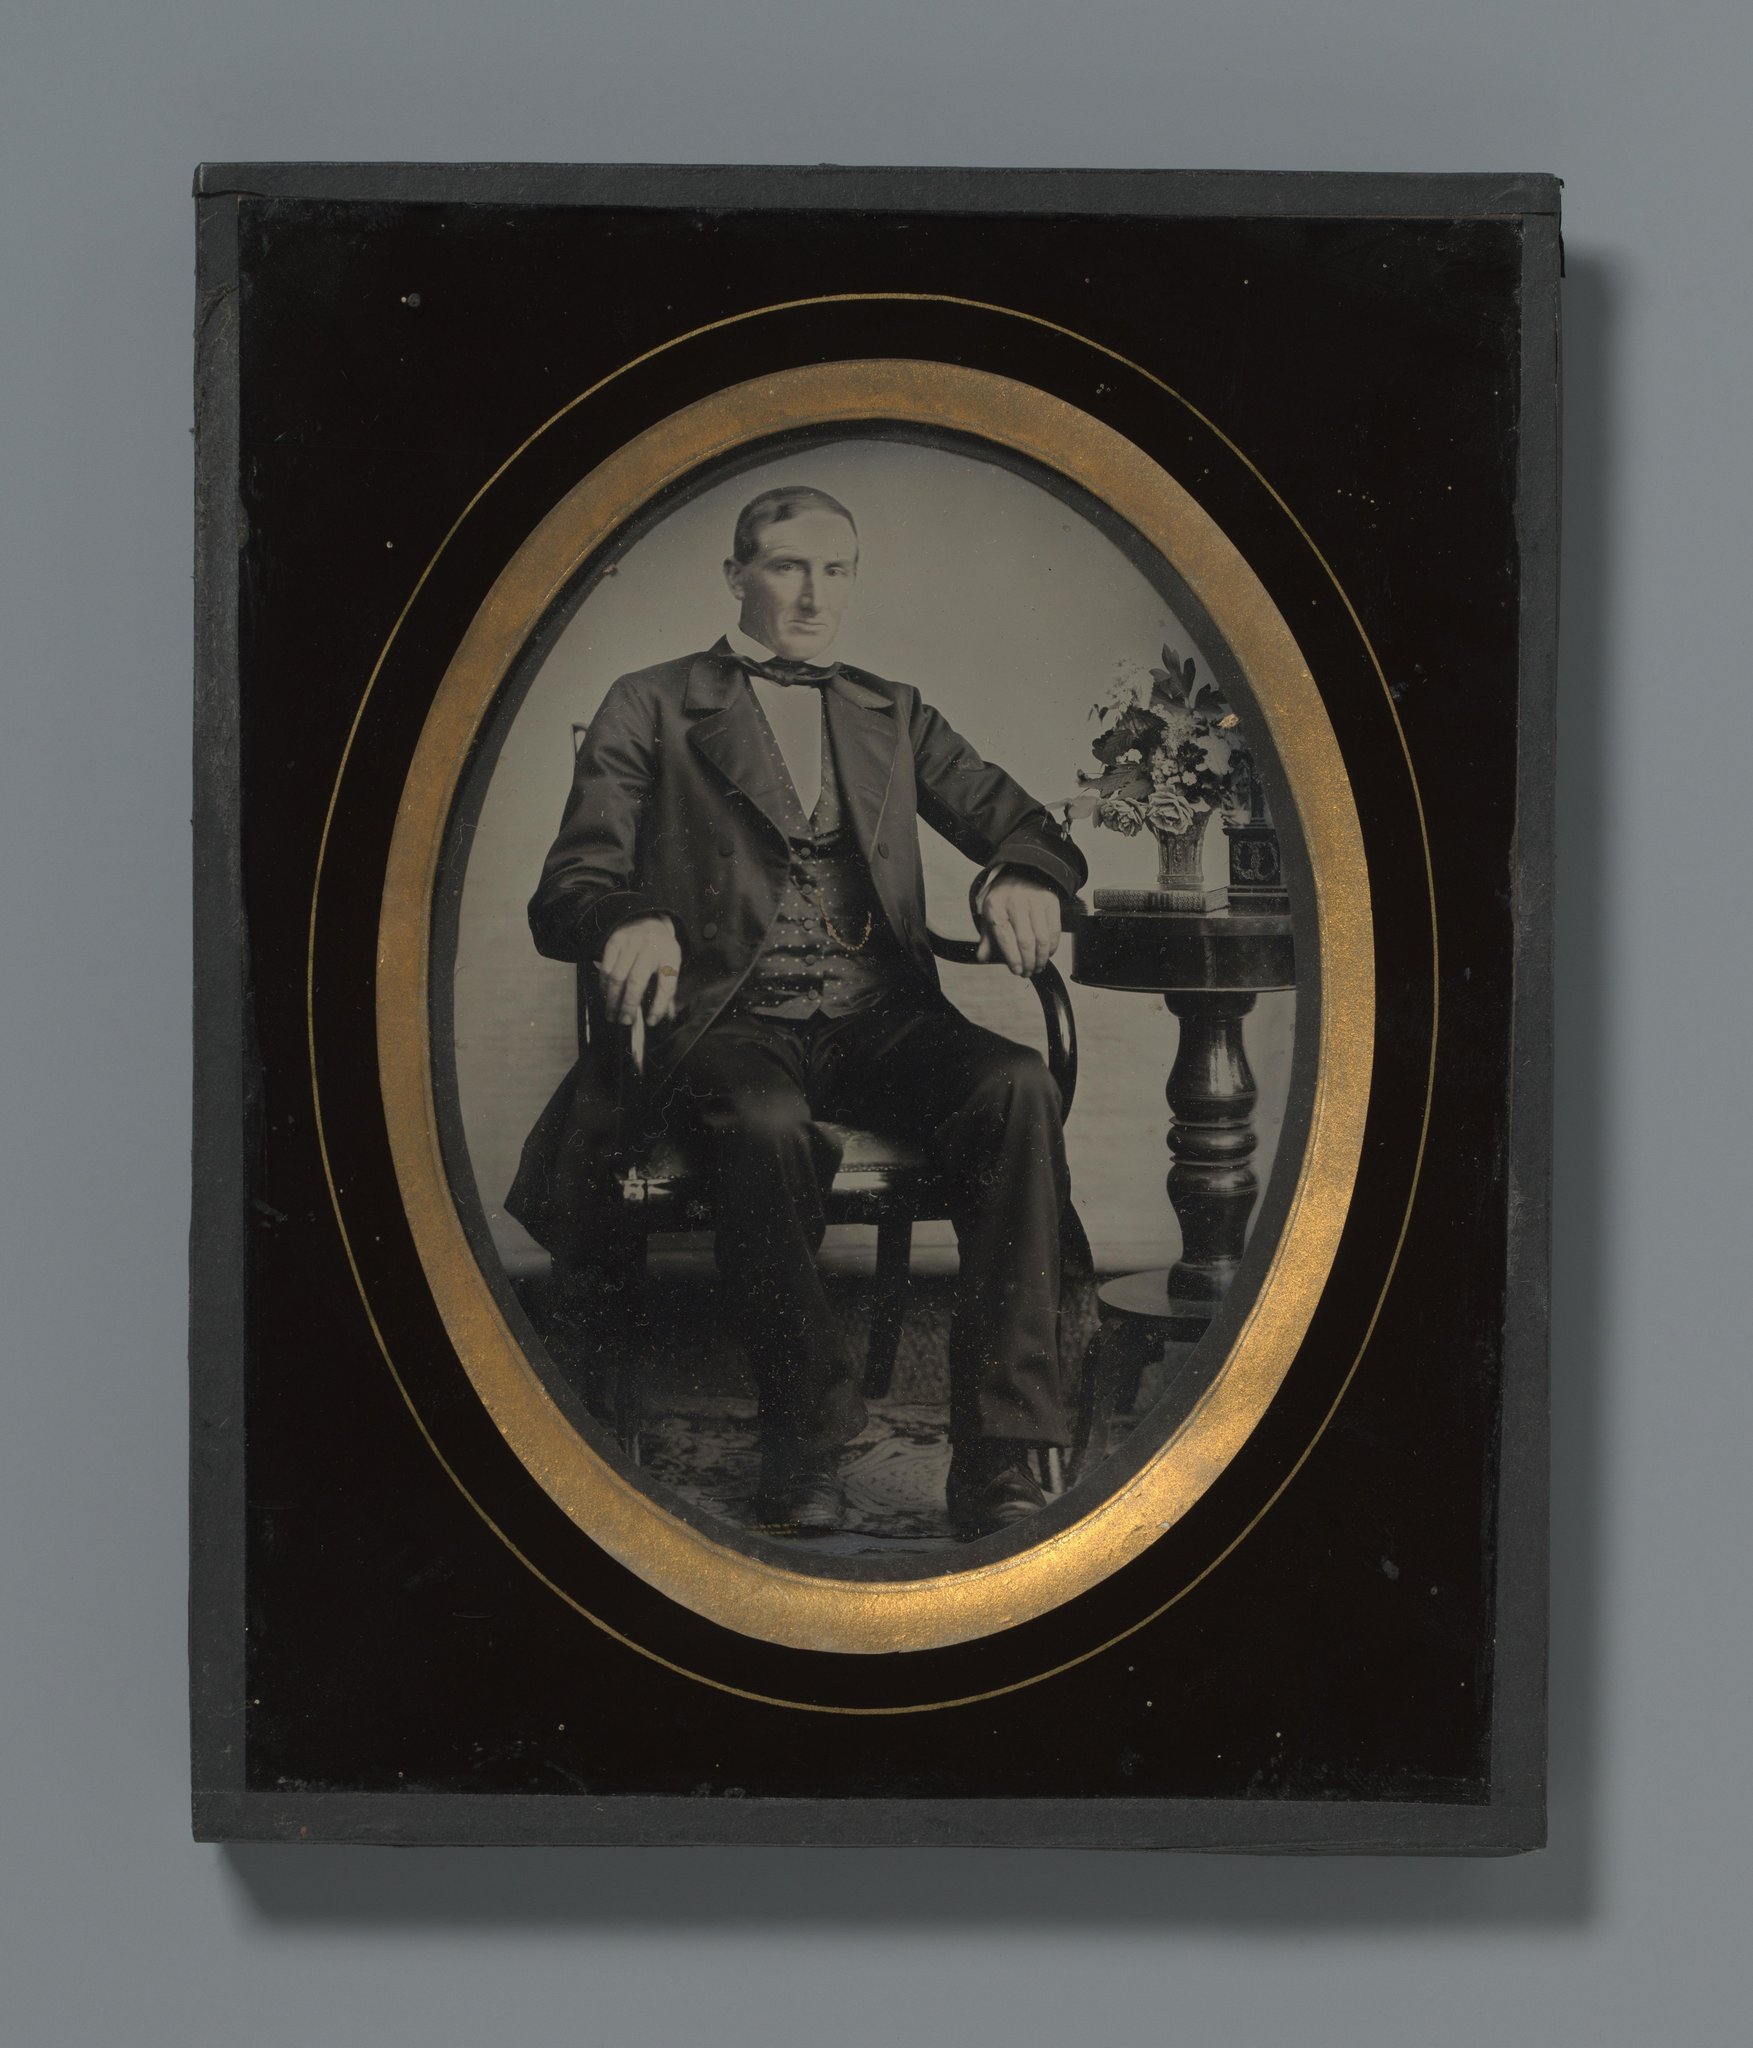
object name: frame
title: Portret van een onbekende zittende man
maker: Anonymous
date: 1855-1870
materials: cardboard, glass, paper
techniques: ambrotype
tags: sitting figure, historical persons